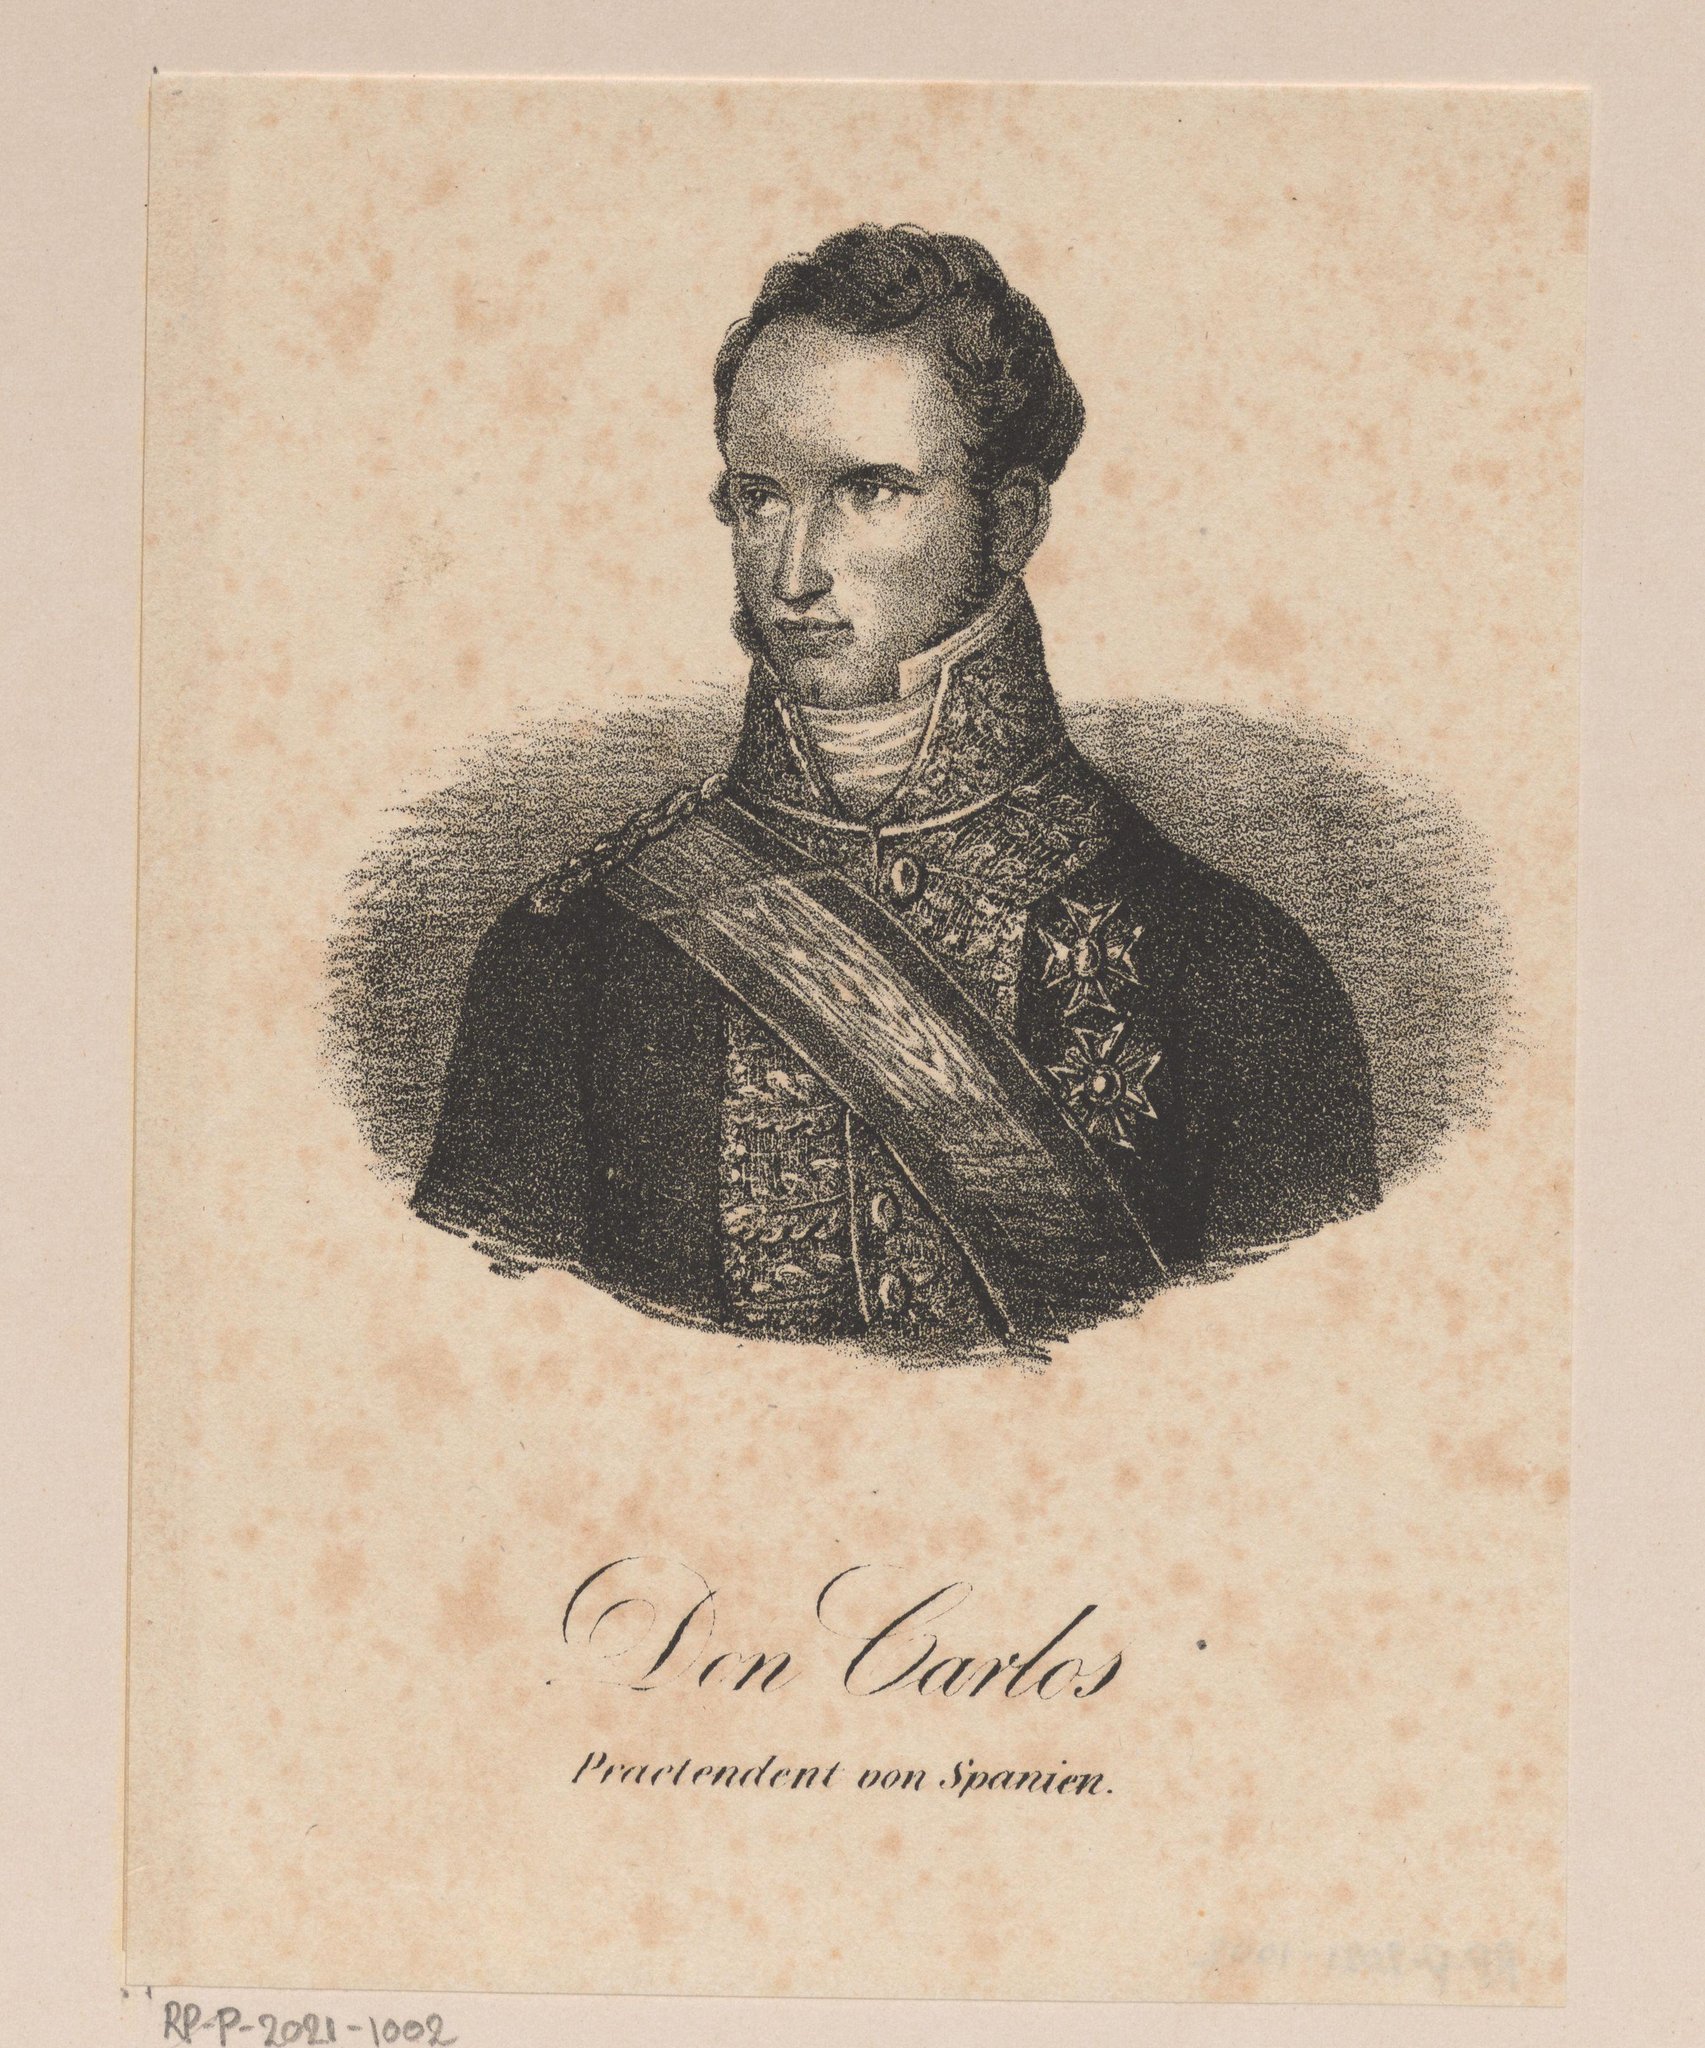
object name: print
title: Portret van Carlos María Isidro Benito de Borbón y Borbón-Parma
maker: Anonymous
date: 1810-1849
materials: paper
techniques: lithograph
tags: earl, historical persons